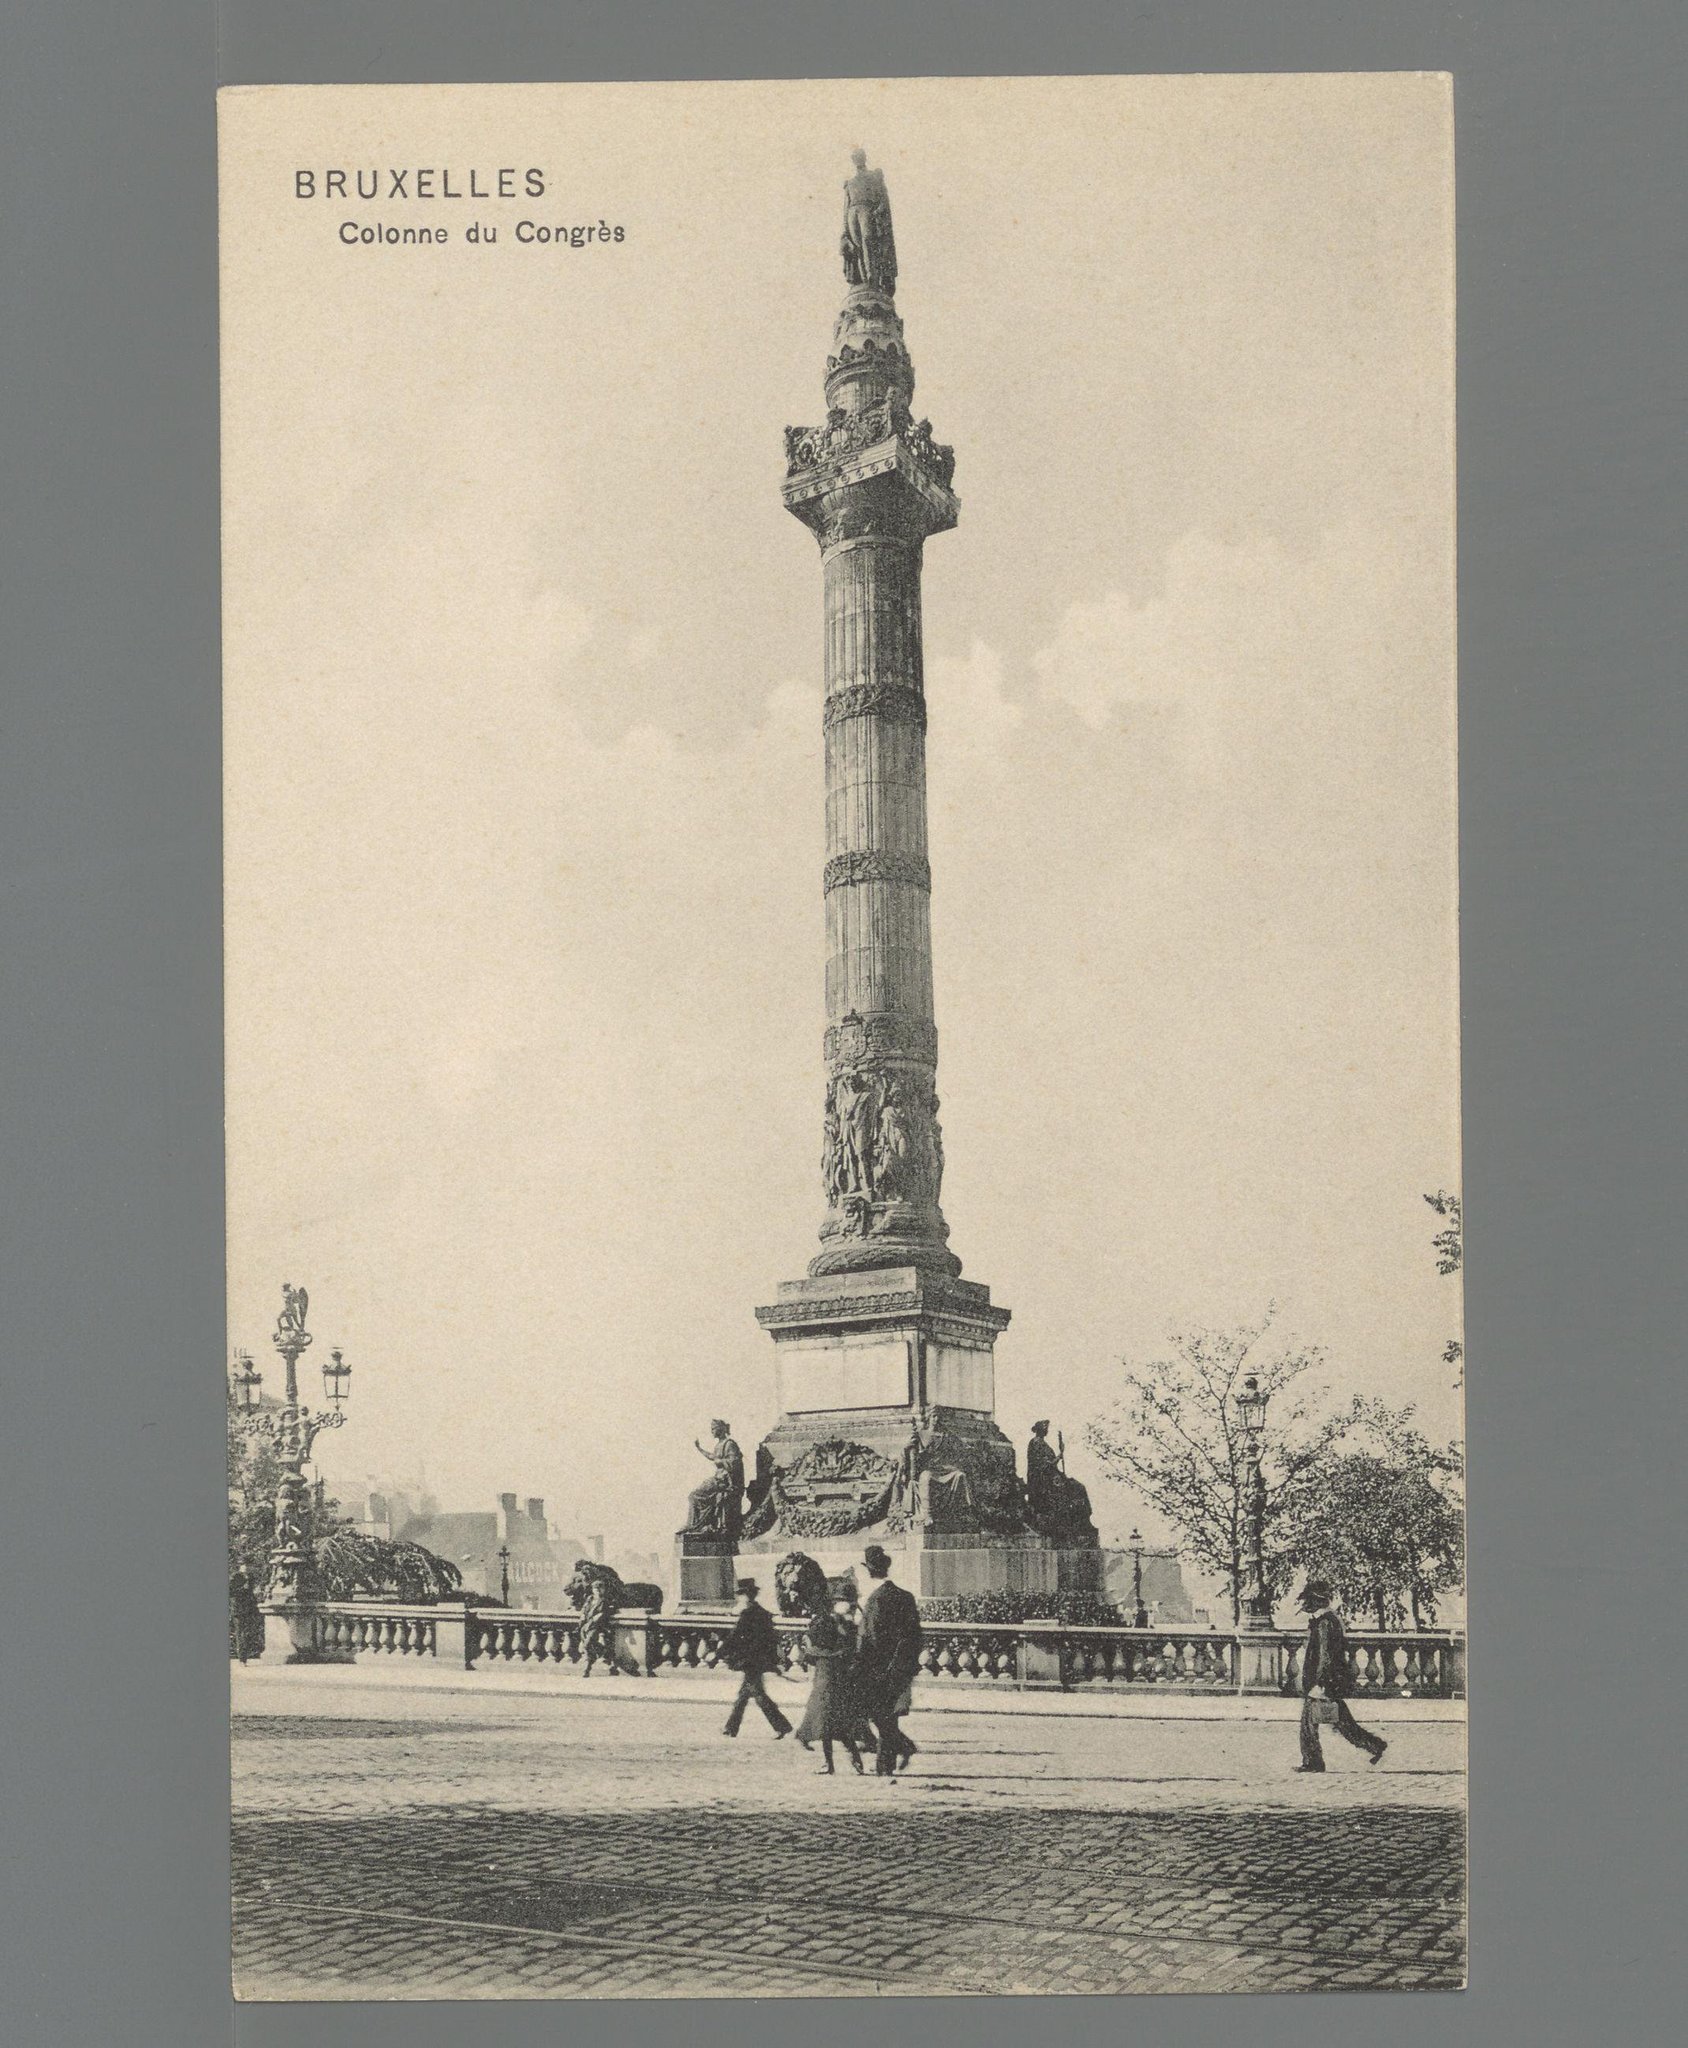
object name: ansichtkaart, prentbriefkaart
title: Brs.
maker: Anonymous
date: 1906-1930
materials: cardboard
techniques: photograph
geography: brussels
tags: monument, statue, city-view, and landscape with man-made constructions (+ city(-scape) with figures, staffage)